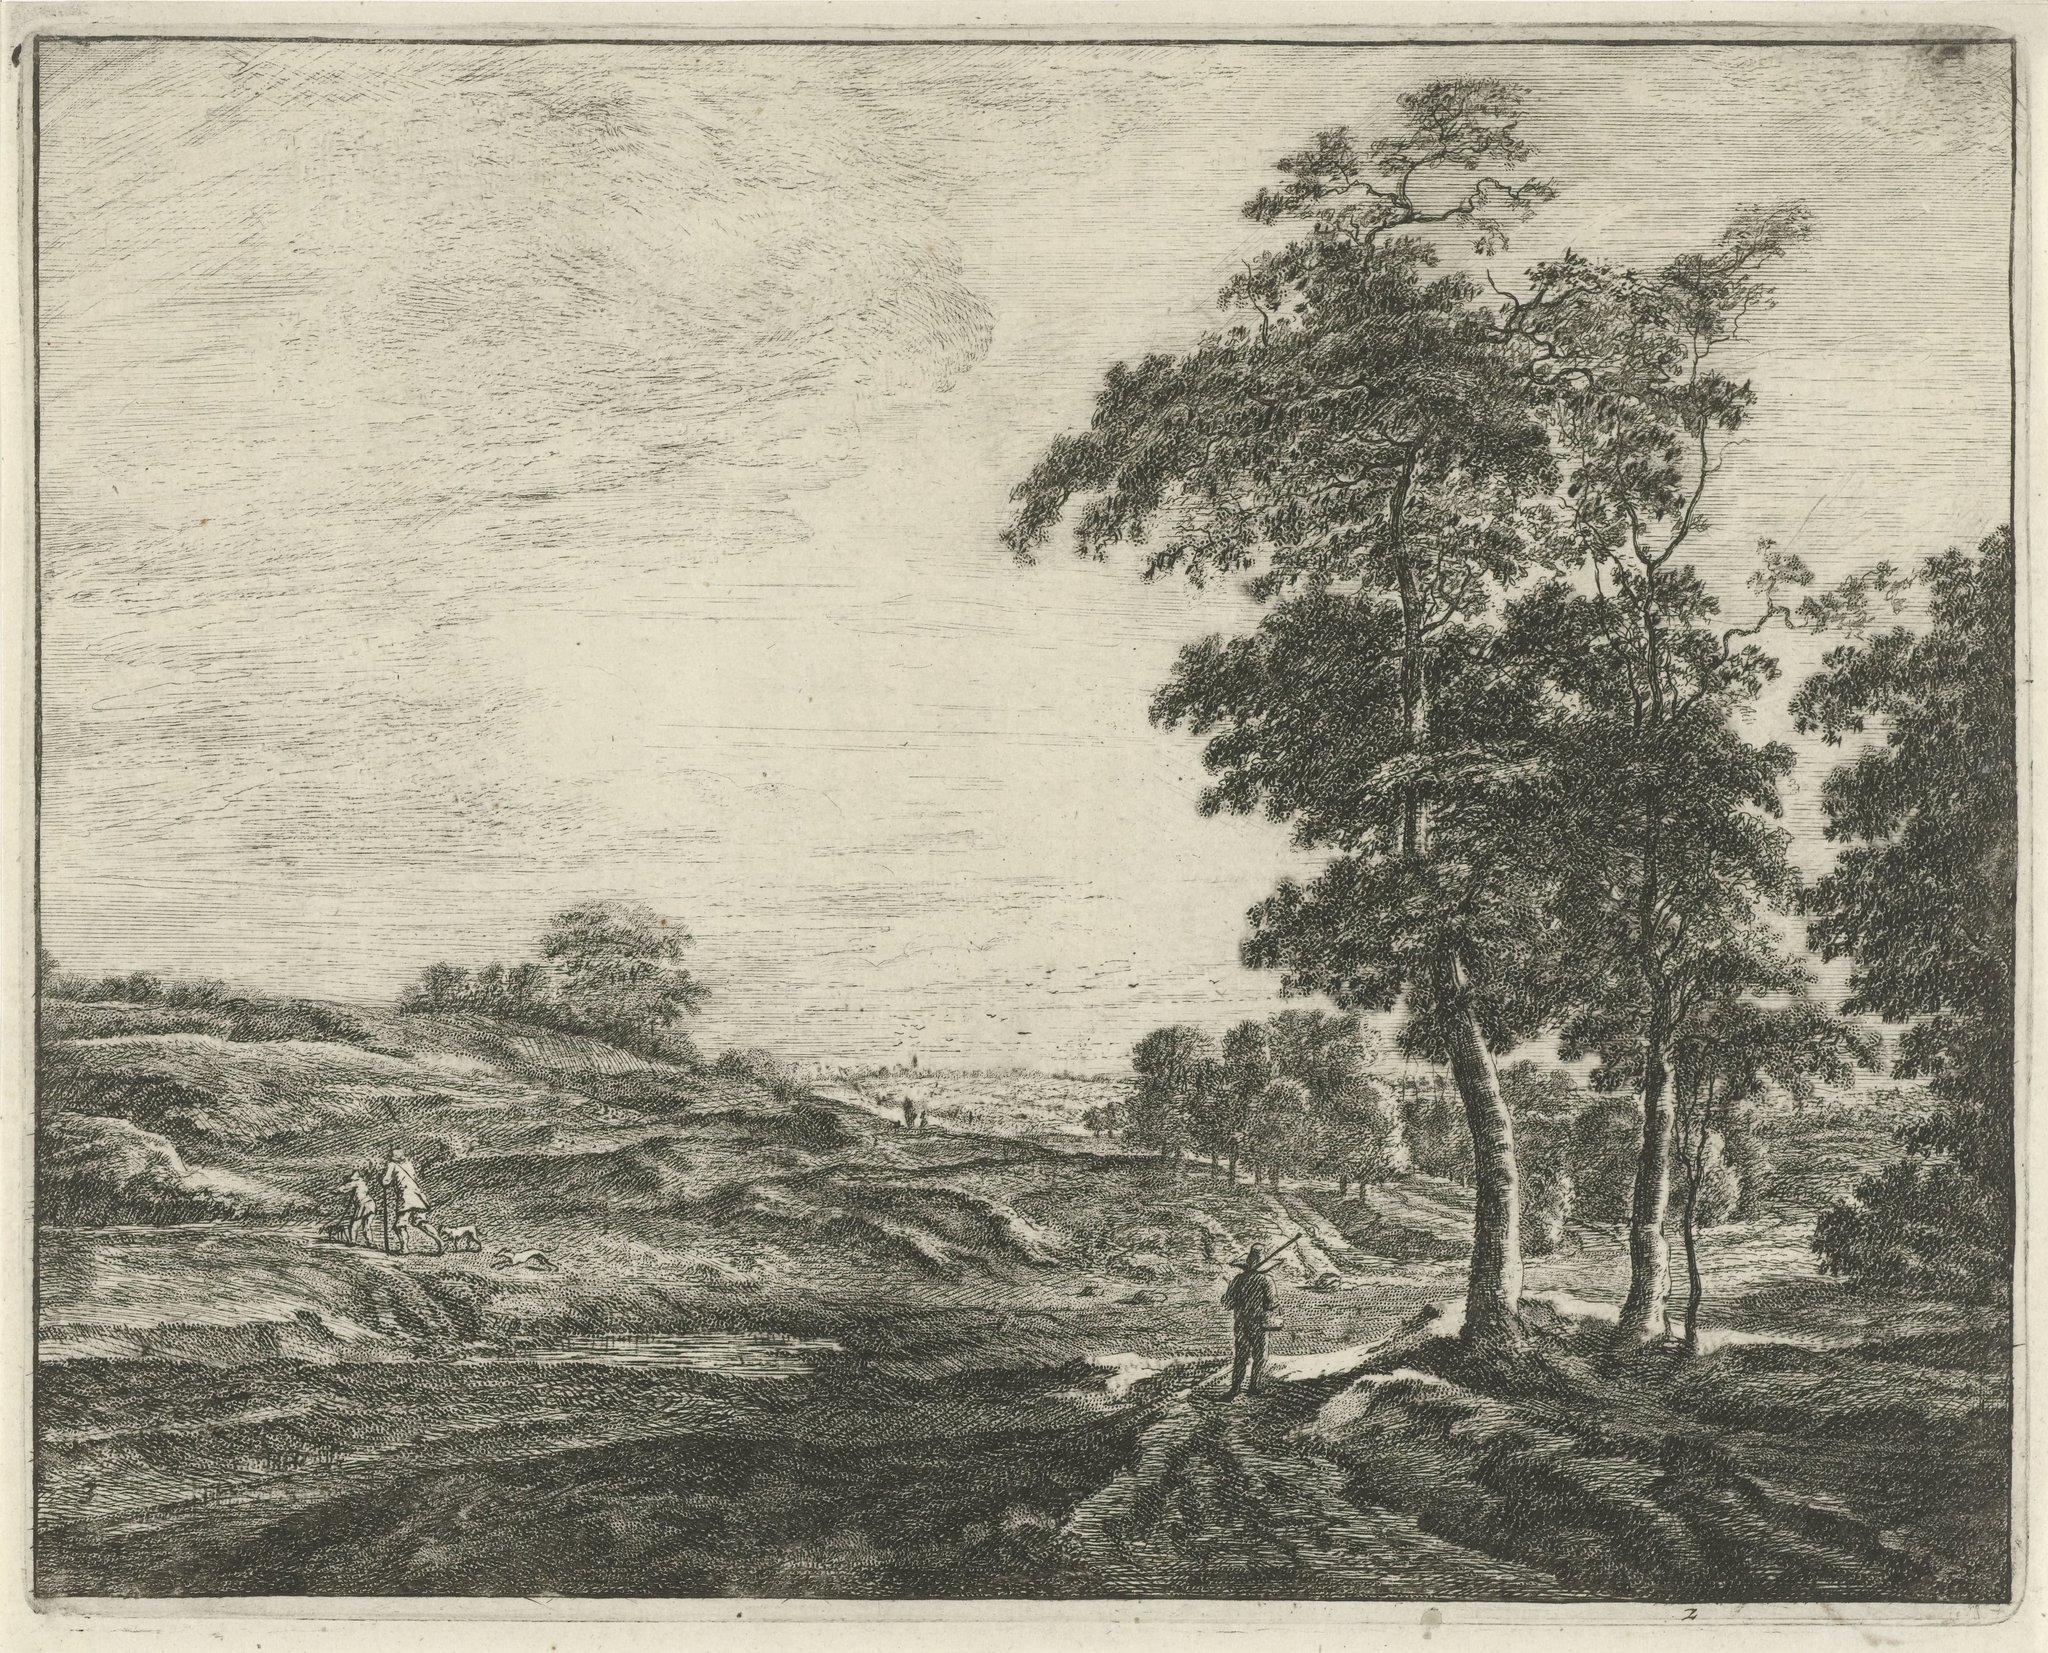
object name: print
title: Aan de rand van het Haagse Bos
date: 1637-1652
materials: paper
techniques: etching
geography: amsterdam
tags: low hill country, forest, wood, dog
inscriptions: collector's mark: Lugt 240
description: Gezicht op een glooiend landschap aan de rand van het Haagse Bos. Op de voorgrond een wandelaar en links twee mannen met honden.